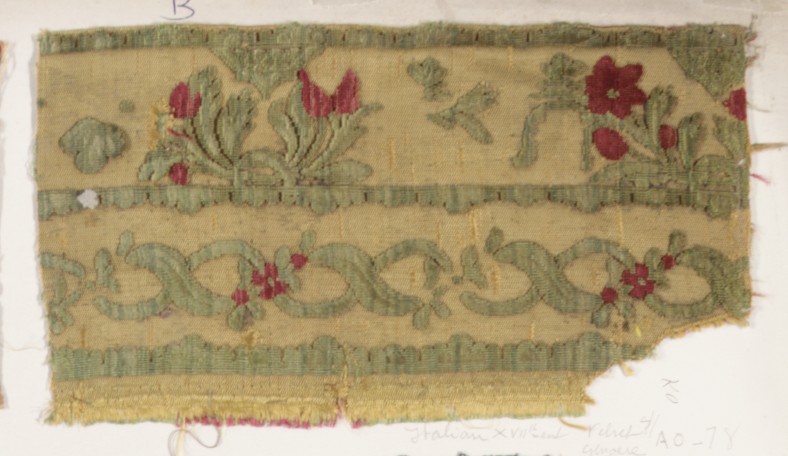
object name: fragment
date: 1501-1700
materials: metal thread, silk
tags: flowers,leaves